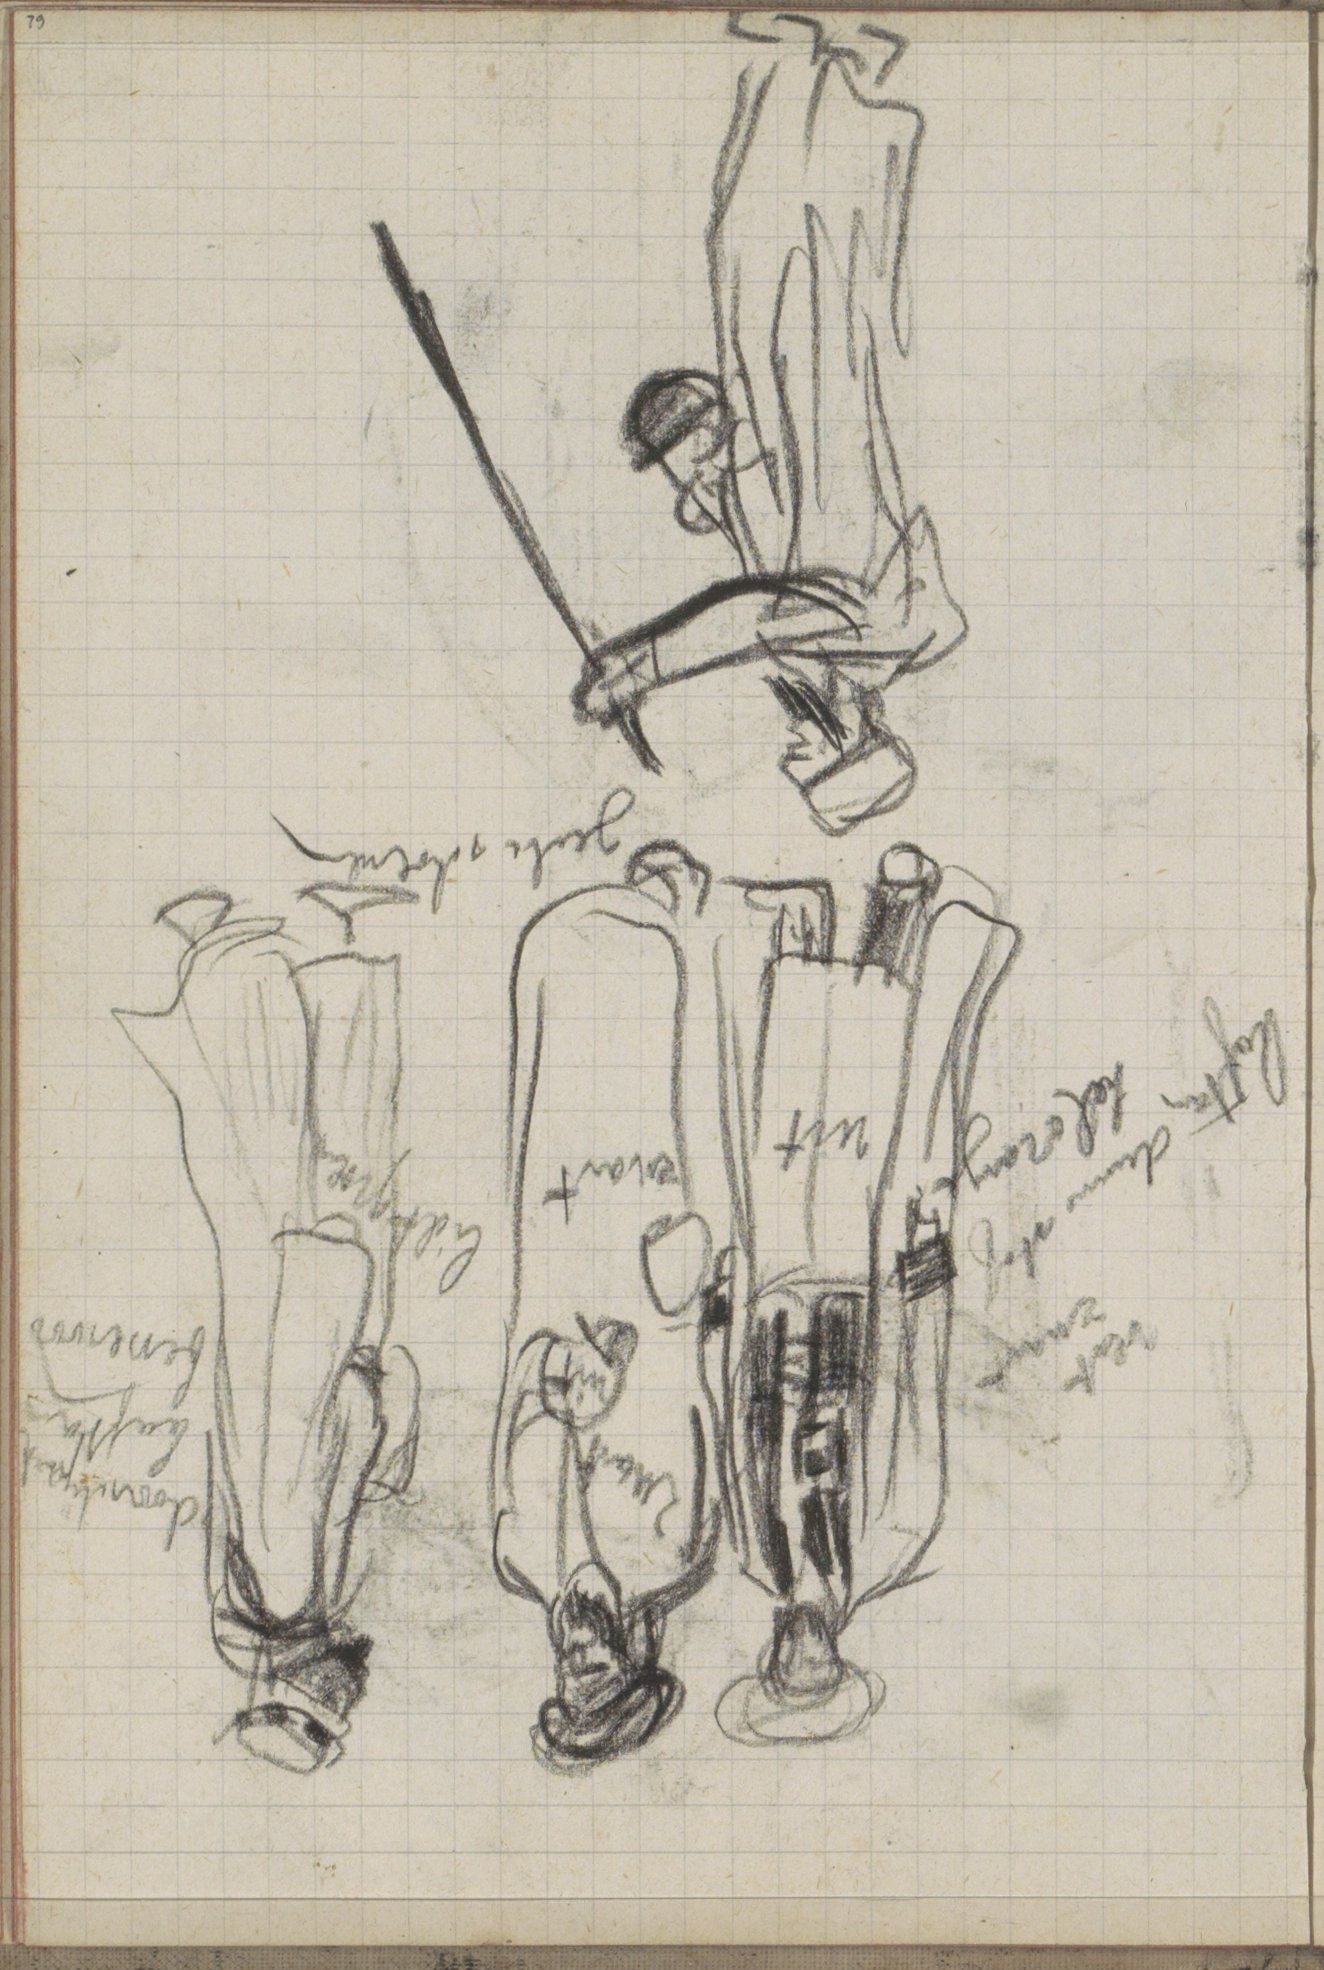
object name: sketchbook leaf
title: Vier staande mannen in oosterse kleding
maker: marius bauer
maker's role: draughtsman, print maker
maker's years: 1867-1932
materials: chalk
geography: istanbul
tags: asiatic races and peoples, standing figure, walking-stick, staff, adult man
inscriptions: kleurnotitie, handgeschreven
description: Waaronder één met een staf. Pagina 79 uit een schetsboek met 54 bladen.